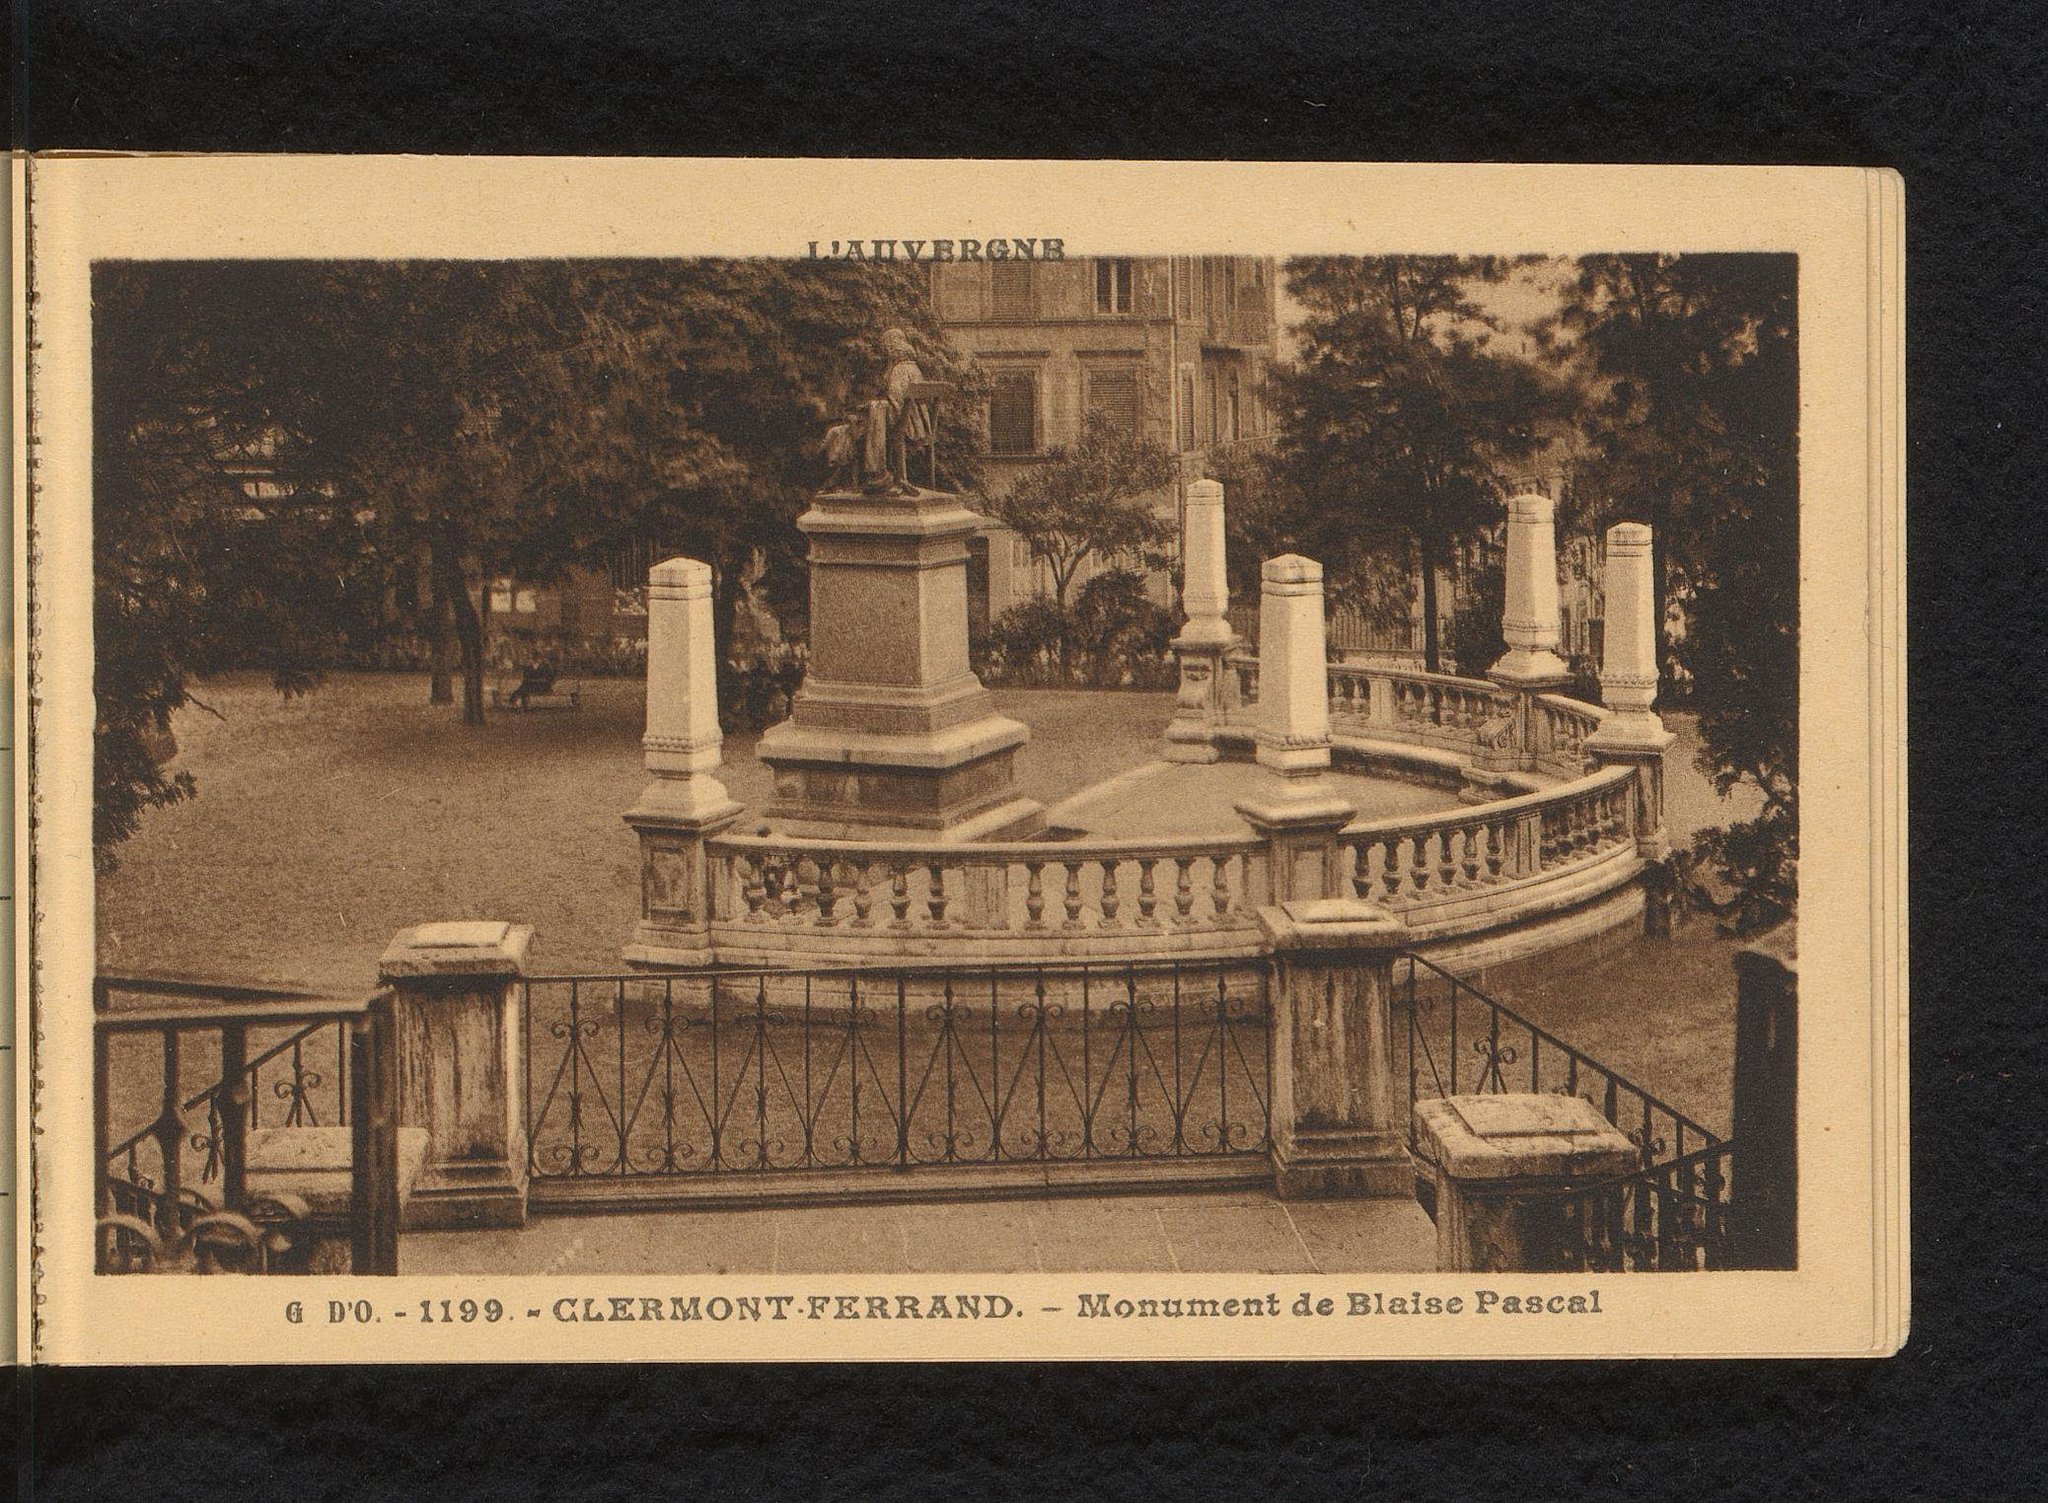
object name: photomechanical print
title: L'Auvergne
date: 1921-1930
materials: cardboard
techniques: photograph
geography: olliergues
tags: paris, monument, statue, public gardens, park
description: Prentbriefkaart maakt deel uit van een album.